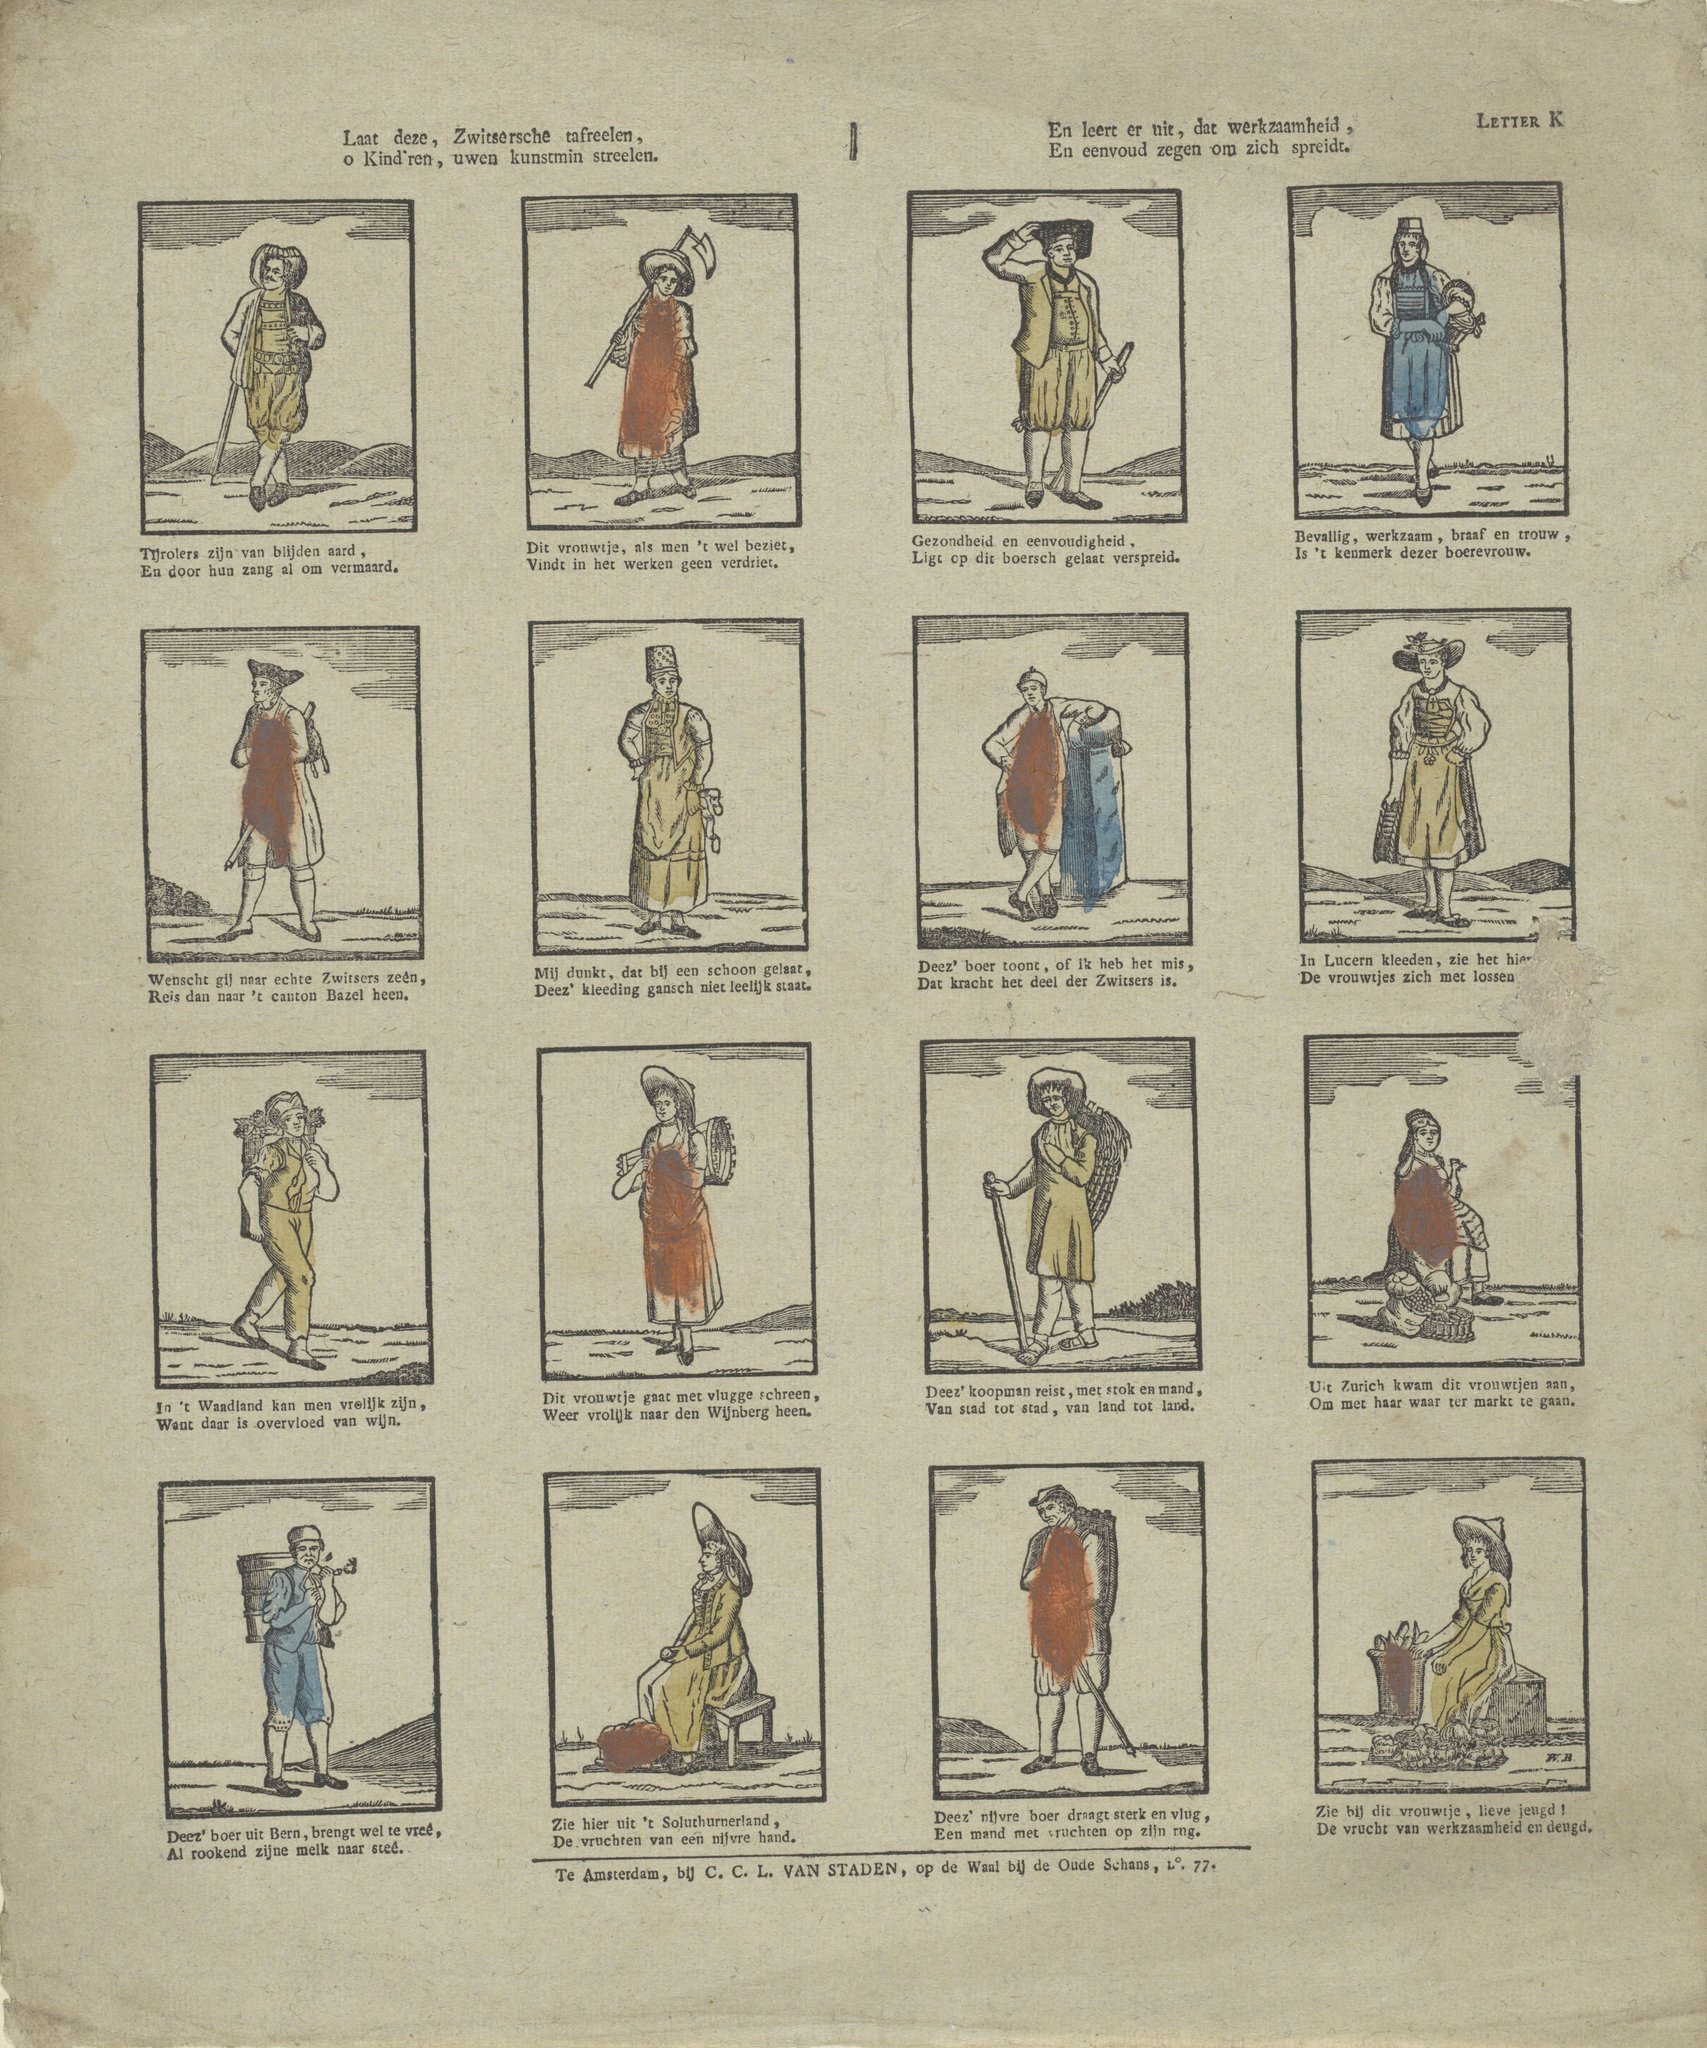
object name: print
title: Laat deze, Zwitsersche tafreelen, / O kind'ren, uwen kunstmin streelen, / En leert er uit, dat werkzaamheid, / En eenvoud zegen om zich spreidt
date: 1822-1870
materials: paper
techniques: colour, letterpress printing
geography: netherlands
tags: europeans (with name), human types, characters (human types), switzerland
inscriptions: collector's mark: Lugt 2760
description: Blad met 16 voorstellingen van verschillende mensen uit Zwitserland. Onder elke voorstelling een tweeregelig vers. Rechtsboven gemerkt: Letter K.